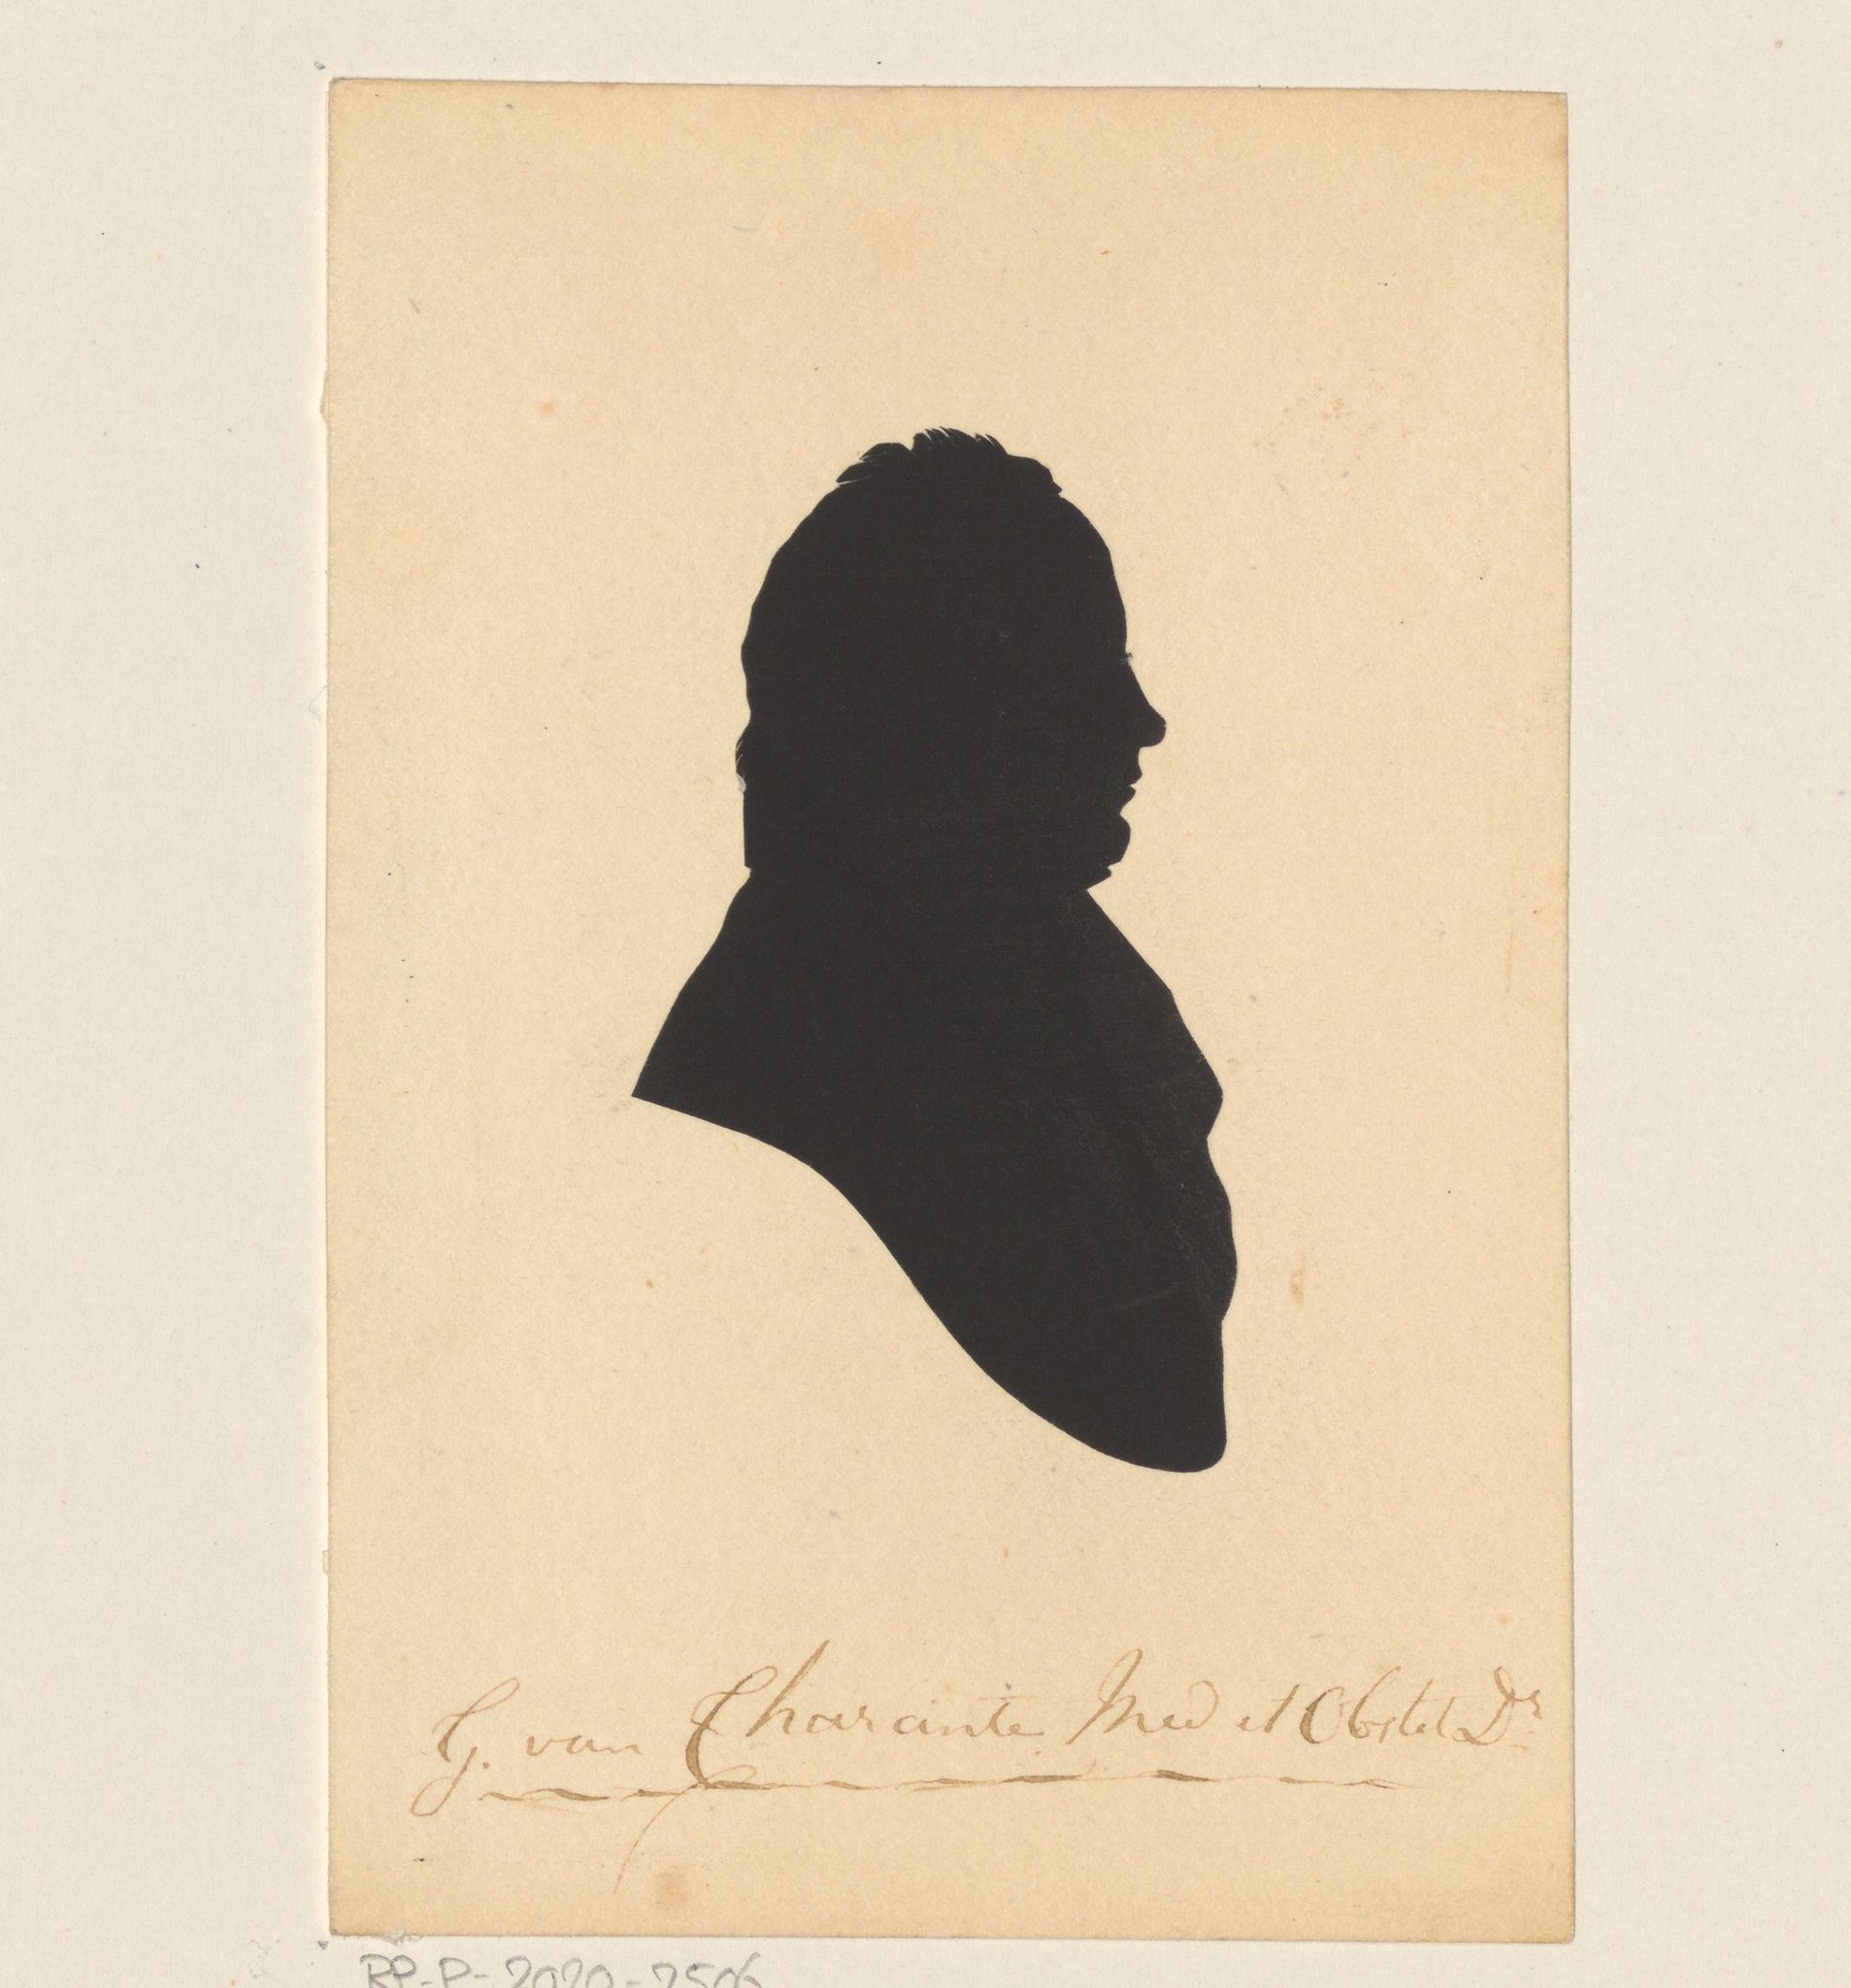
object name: silhouette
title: Silhouetportret van Gabriel van Charante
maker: Anonymous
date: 1819-1866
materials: paper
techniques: snipping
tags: rotterdam, historical persons